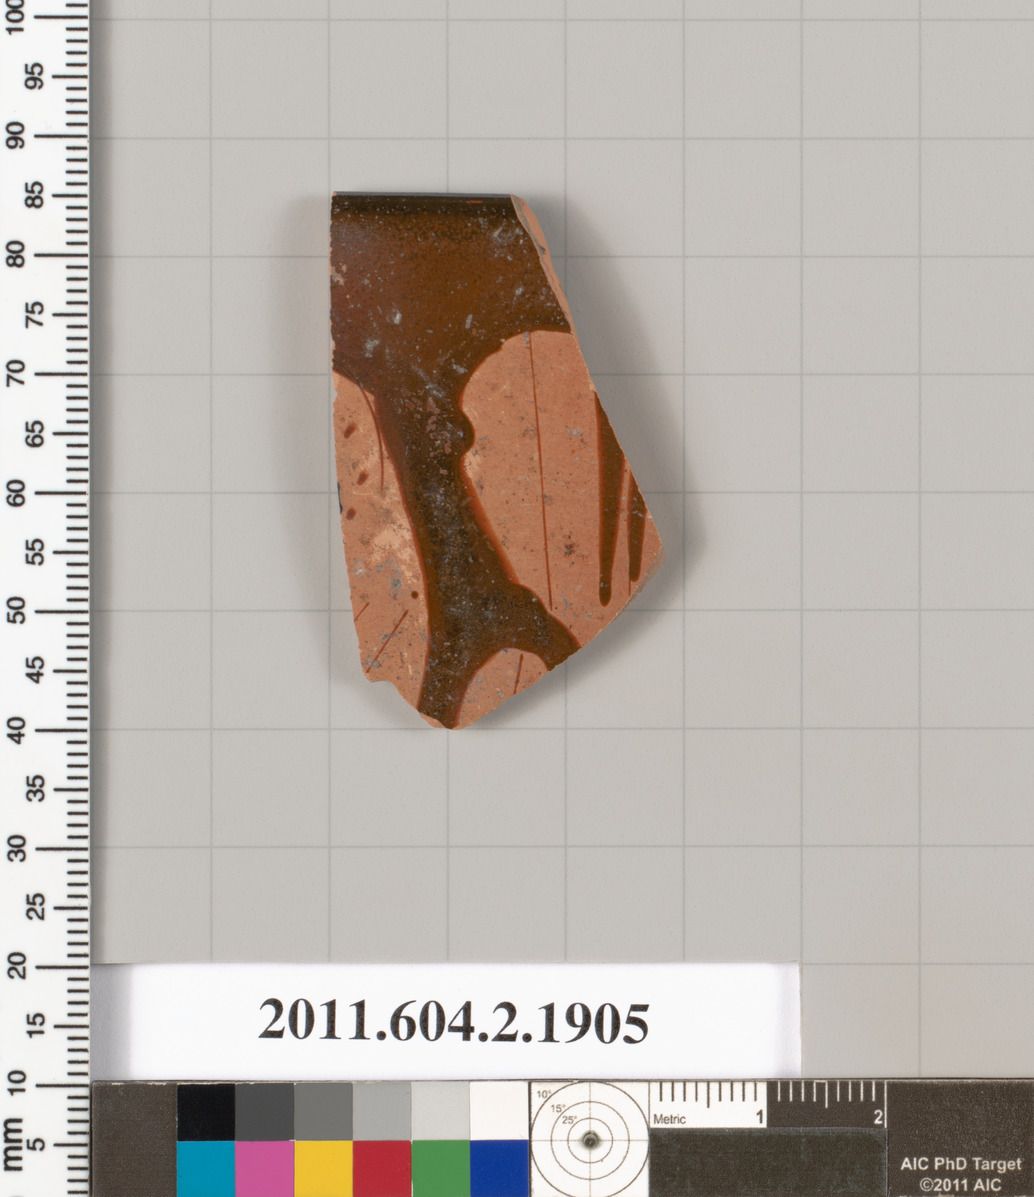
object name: skyphos fragment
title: Terracotta fragment of a skyphos (deep drinking cup)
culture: greek, attic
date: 460-430 BCE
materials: terracotta